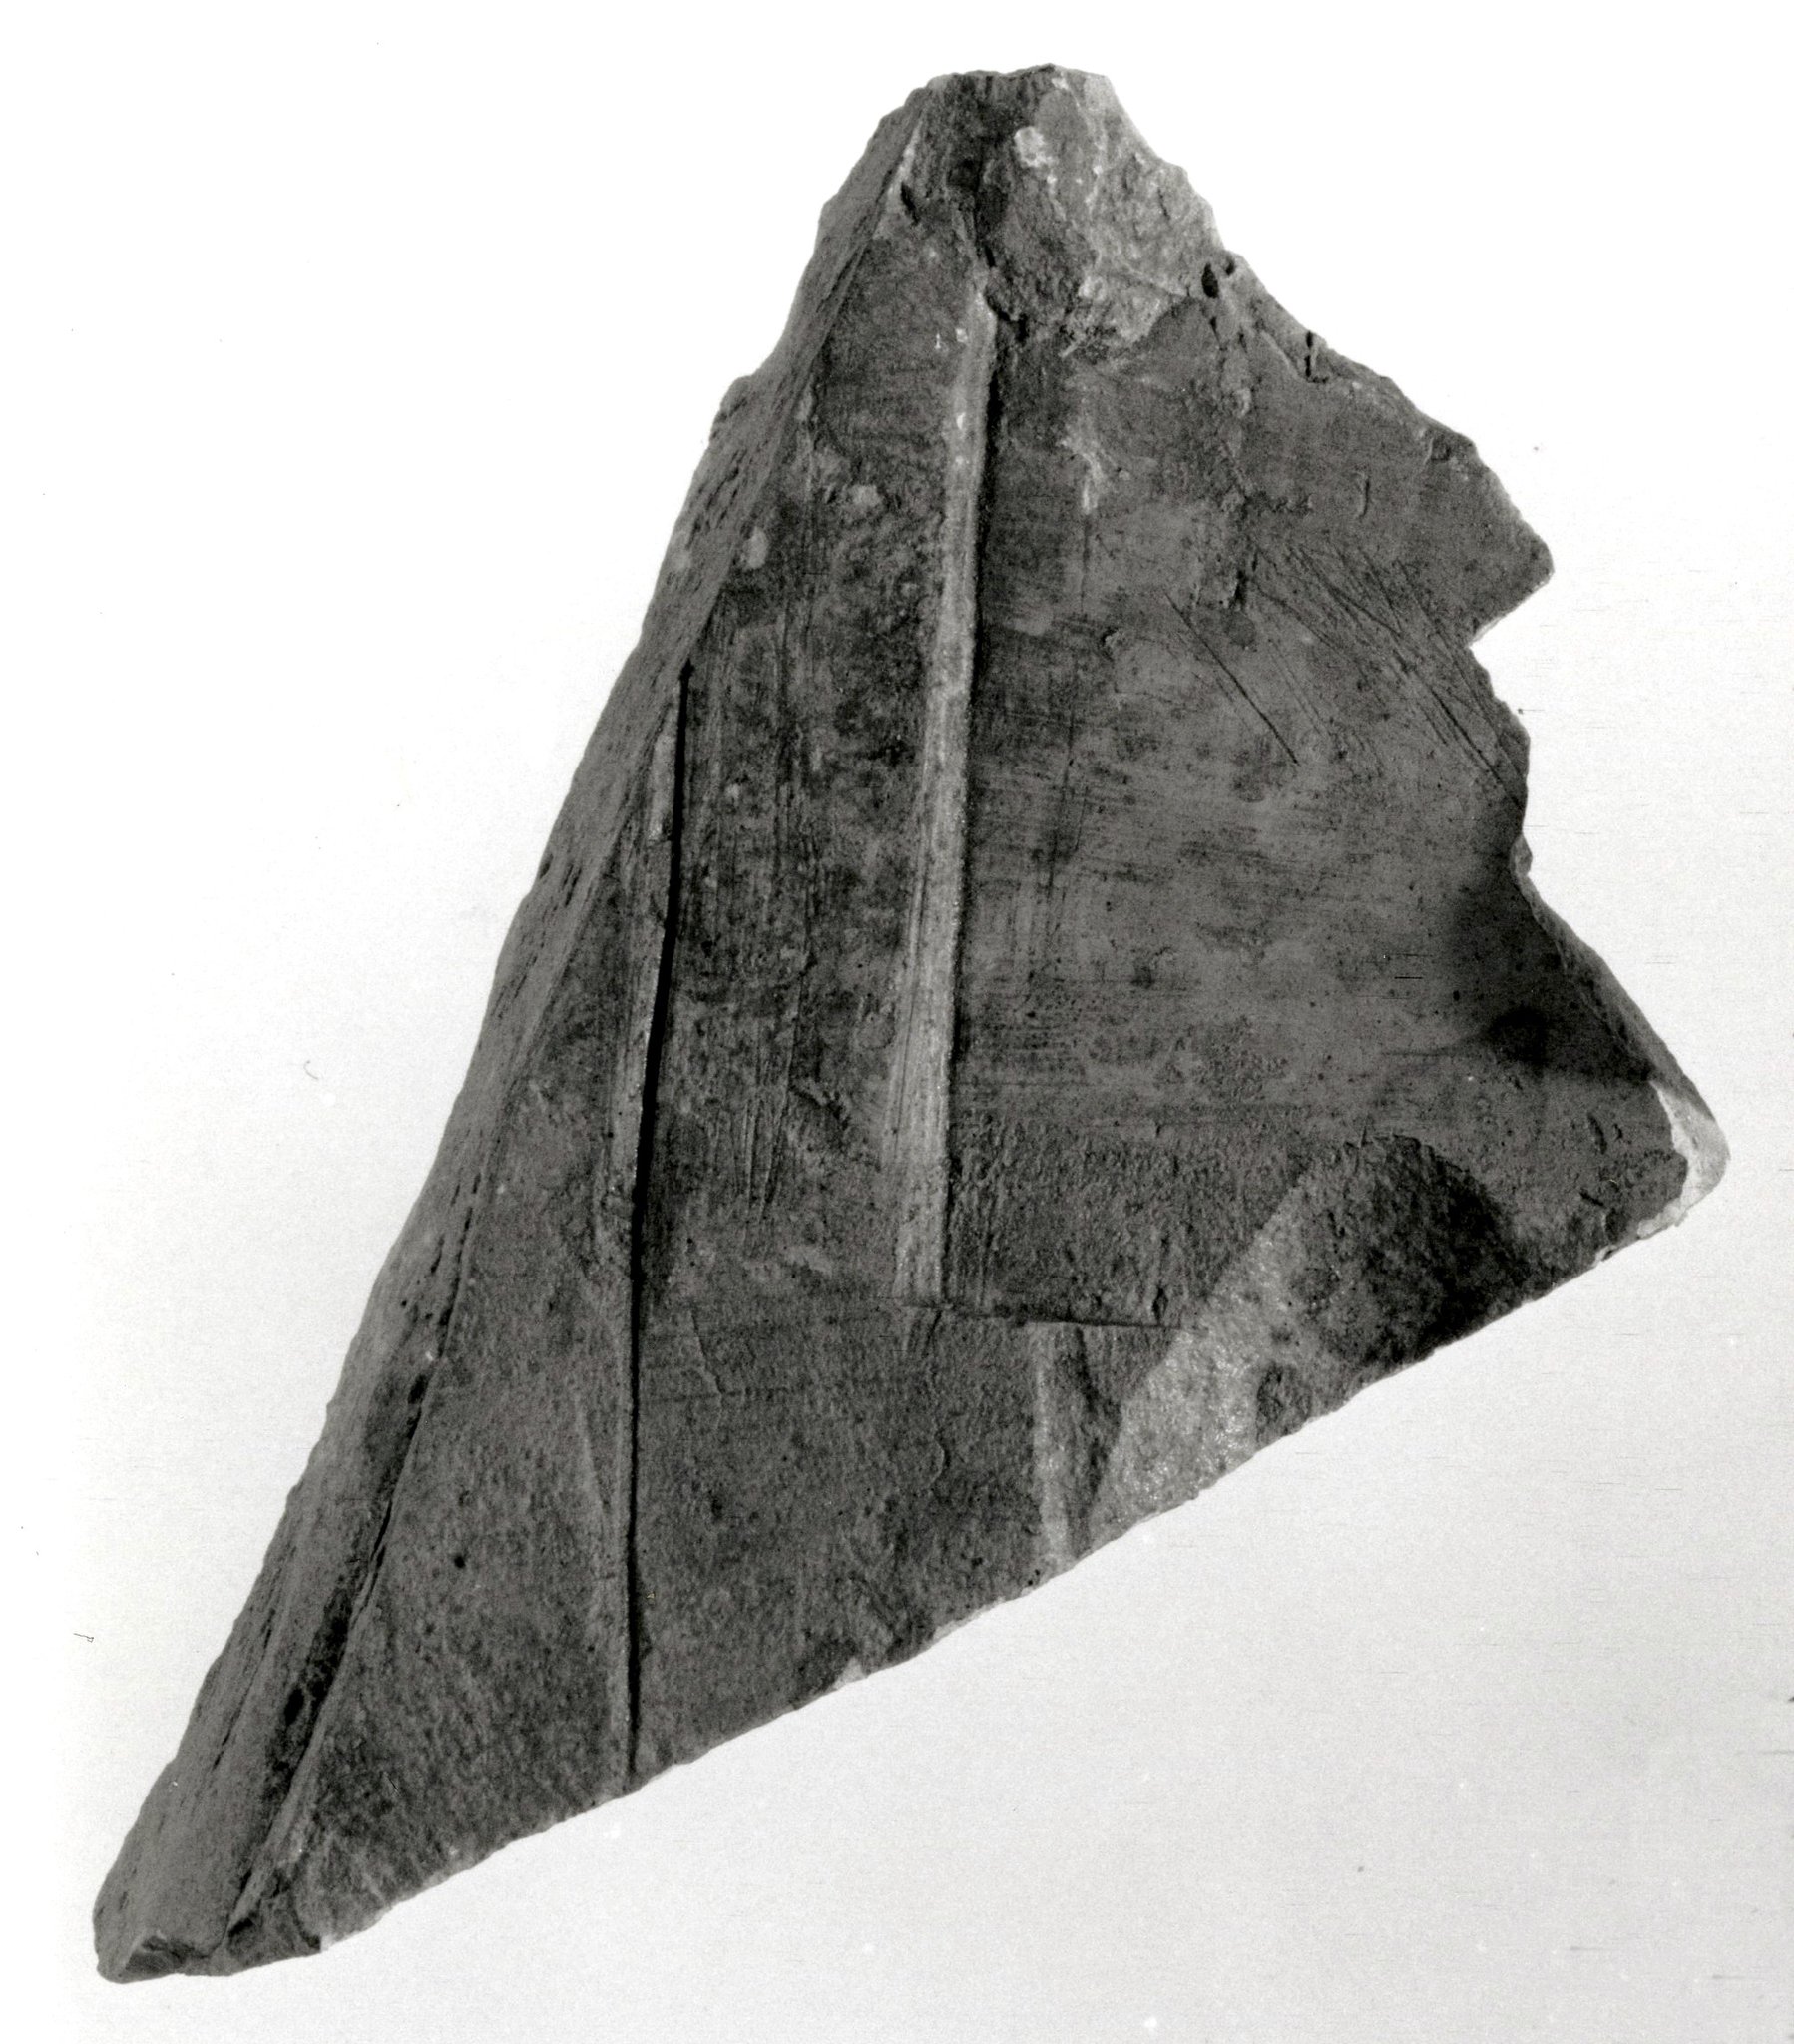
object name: relief, tomb of nespekashuty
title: Raised relief fragment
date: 664-610 BCE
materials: limestone, mortar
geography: egypt